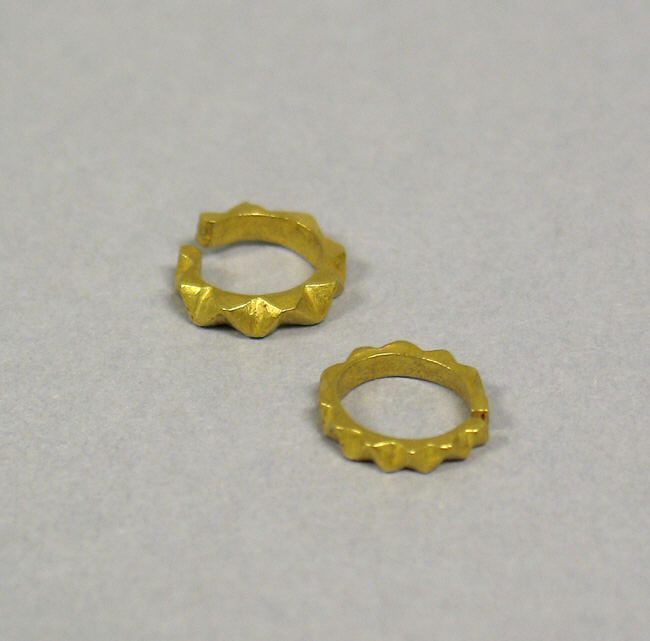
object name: pair of earring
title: Pair of Earrings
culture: indonesian, central java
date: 701-1200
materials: gold